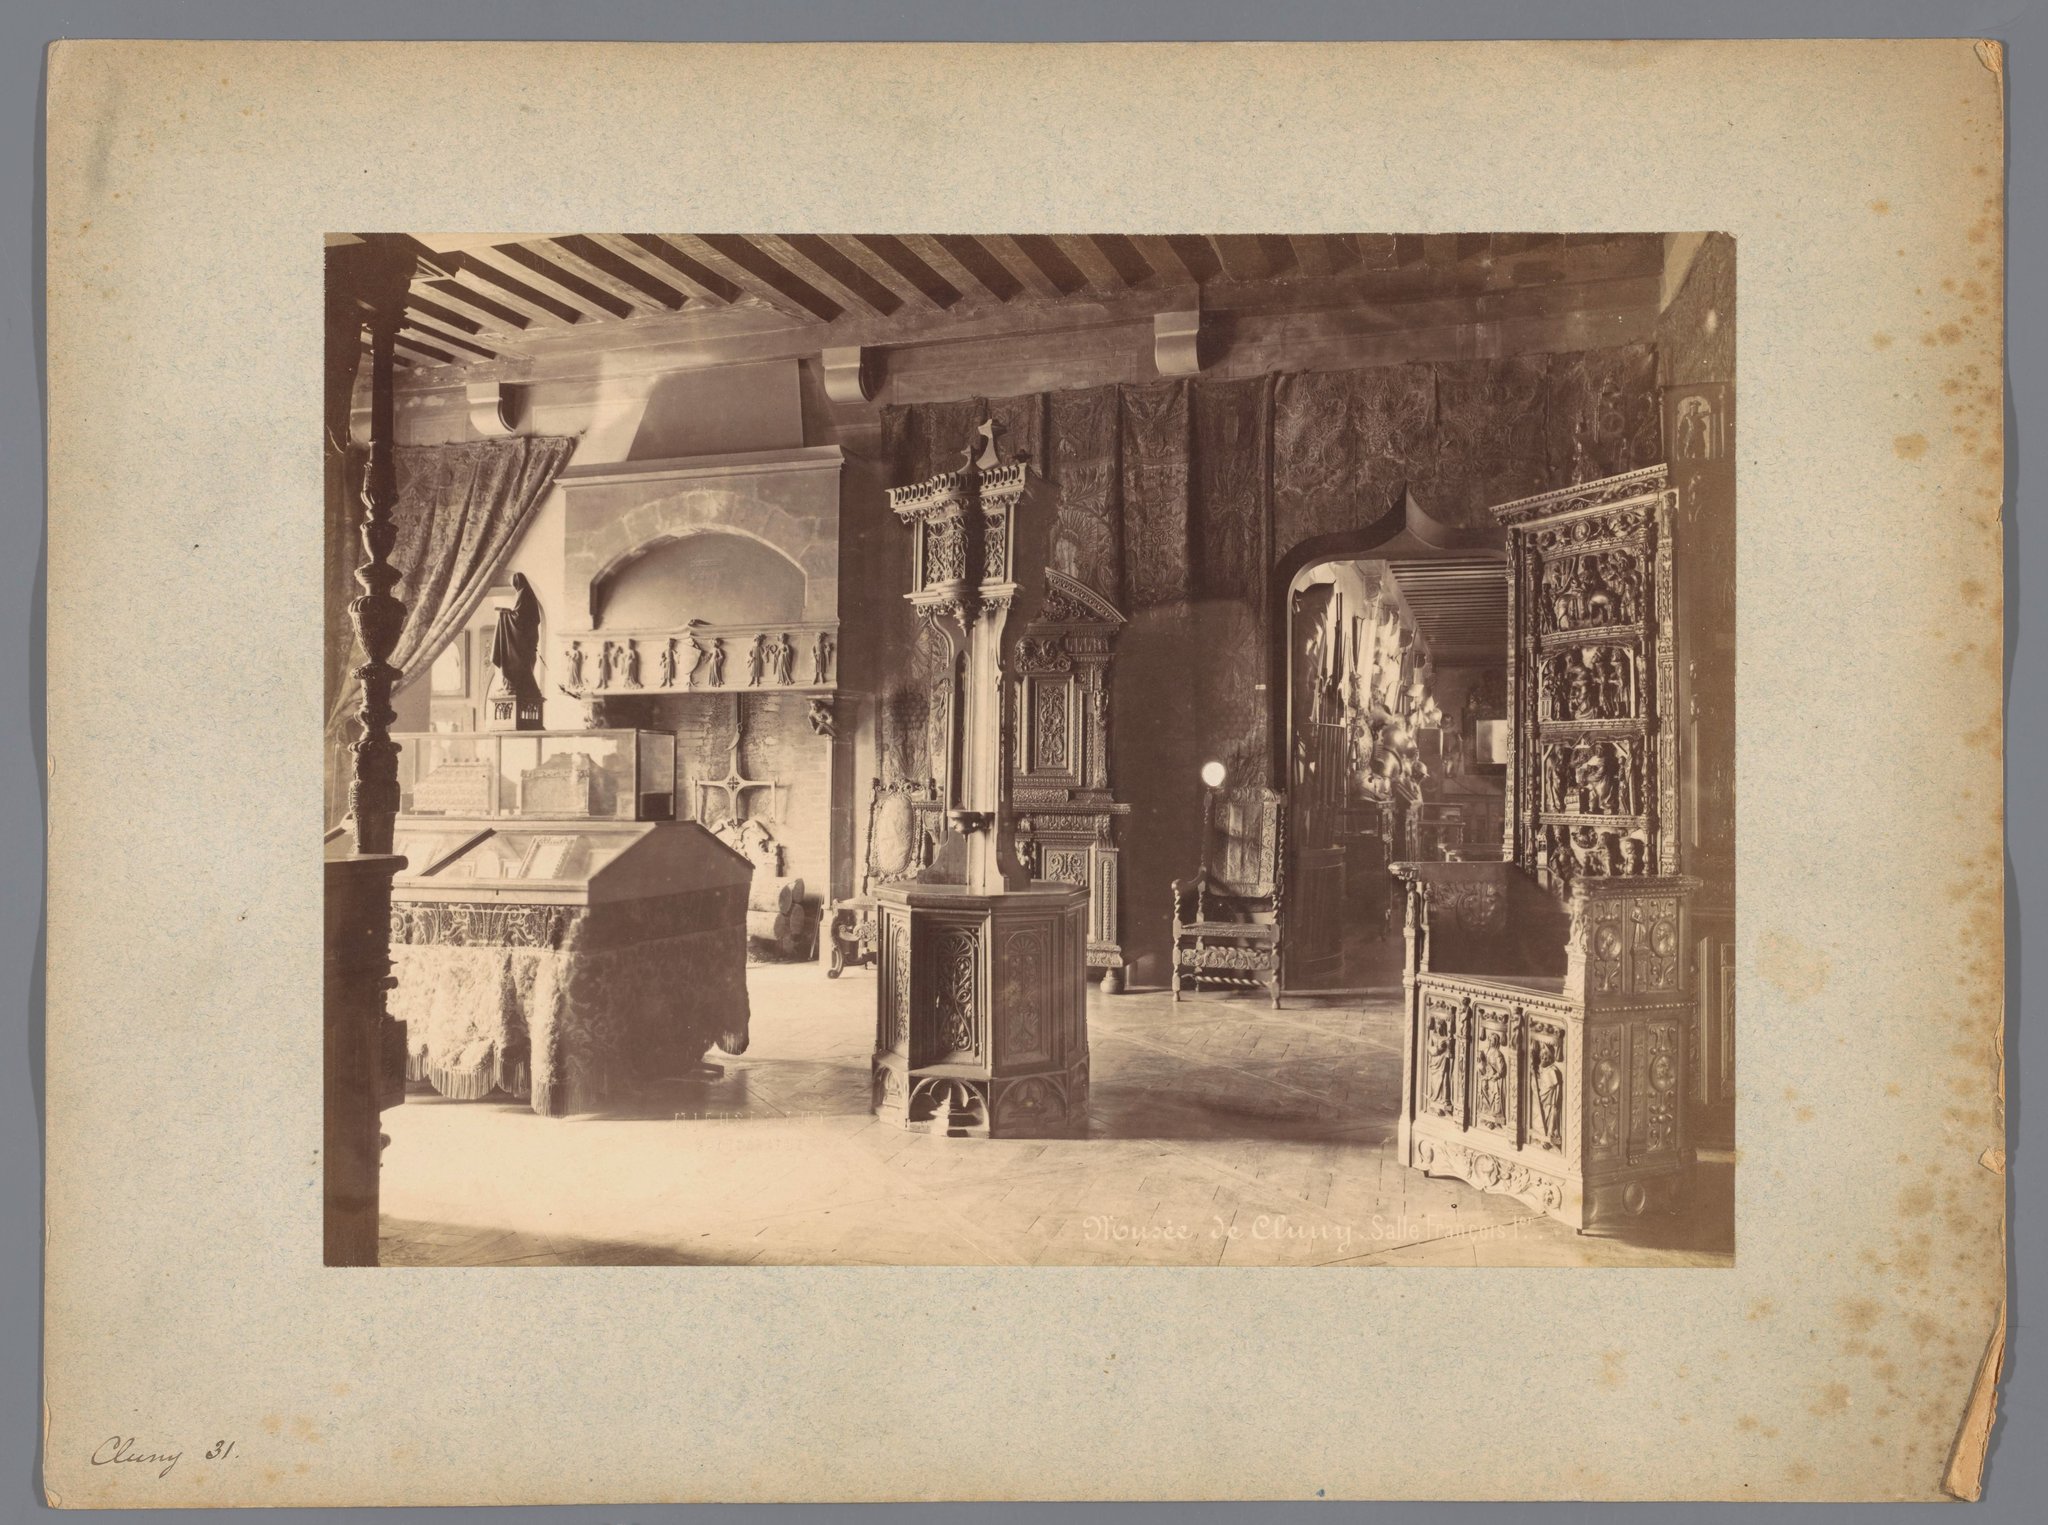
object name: photograph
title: Salle François Ier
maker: séraphin-médéric mieusement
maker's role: fotograaf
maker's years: 1840-1905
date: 1850-1900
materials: cardboard, photographic support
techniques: albumen print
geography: paris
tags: permanent exhibition, museum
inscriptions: workshop stamp: ‘Mieusement/ Photographe’, number: ‘Cluny 31’, collector's mark: ‘Rijks-normaalschool voor teekenonderwijzers Amsterdam’ Lugt 3937